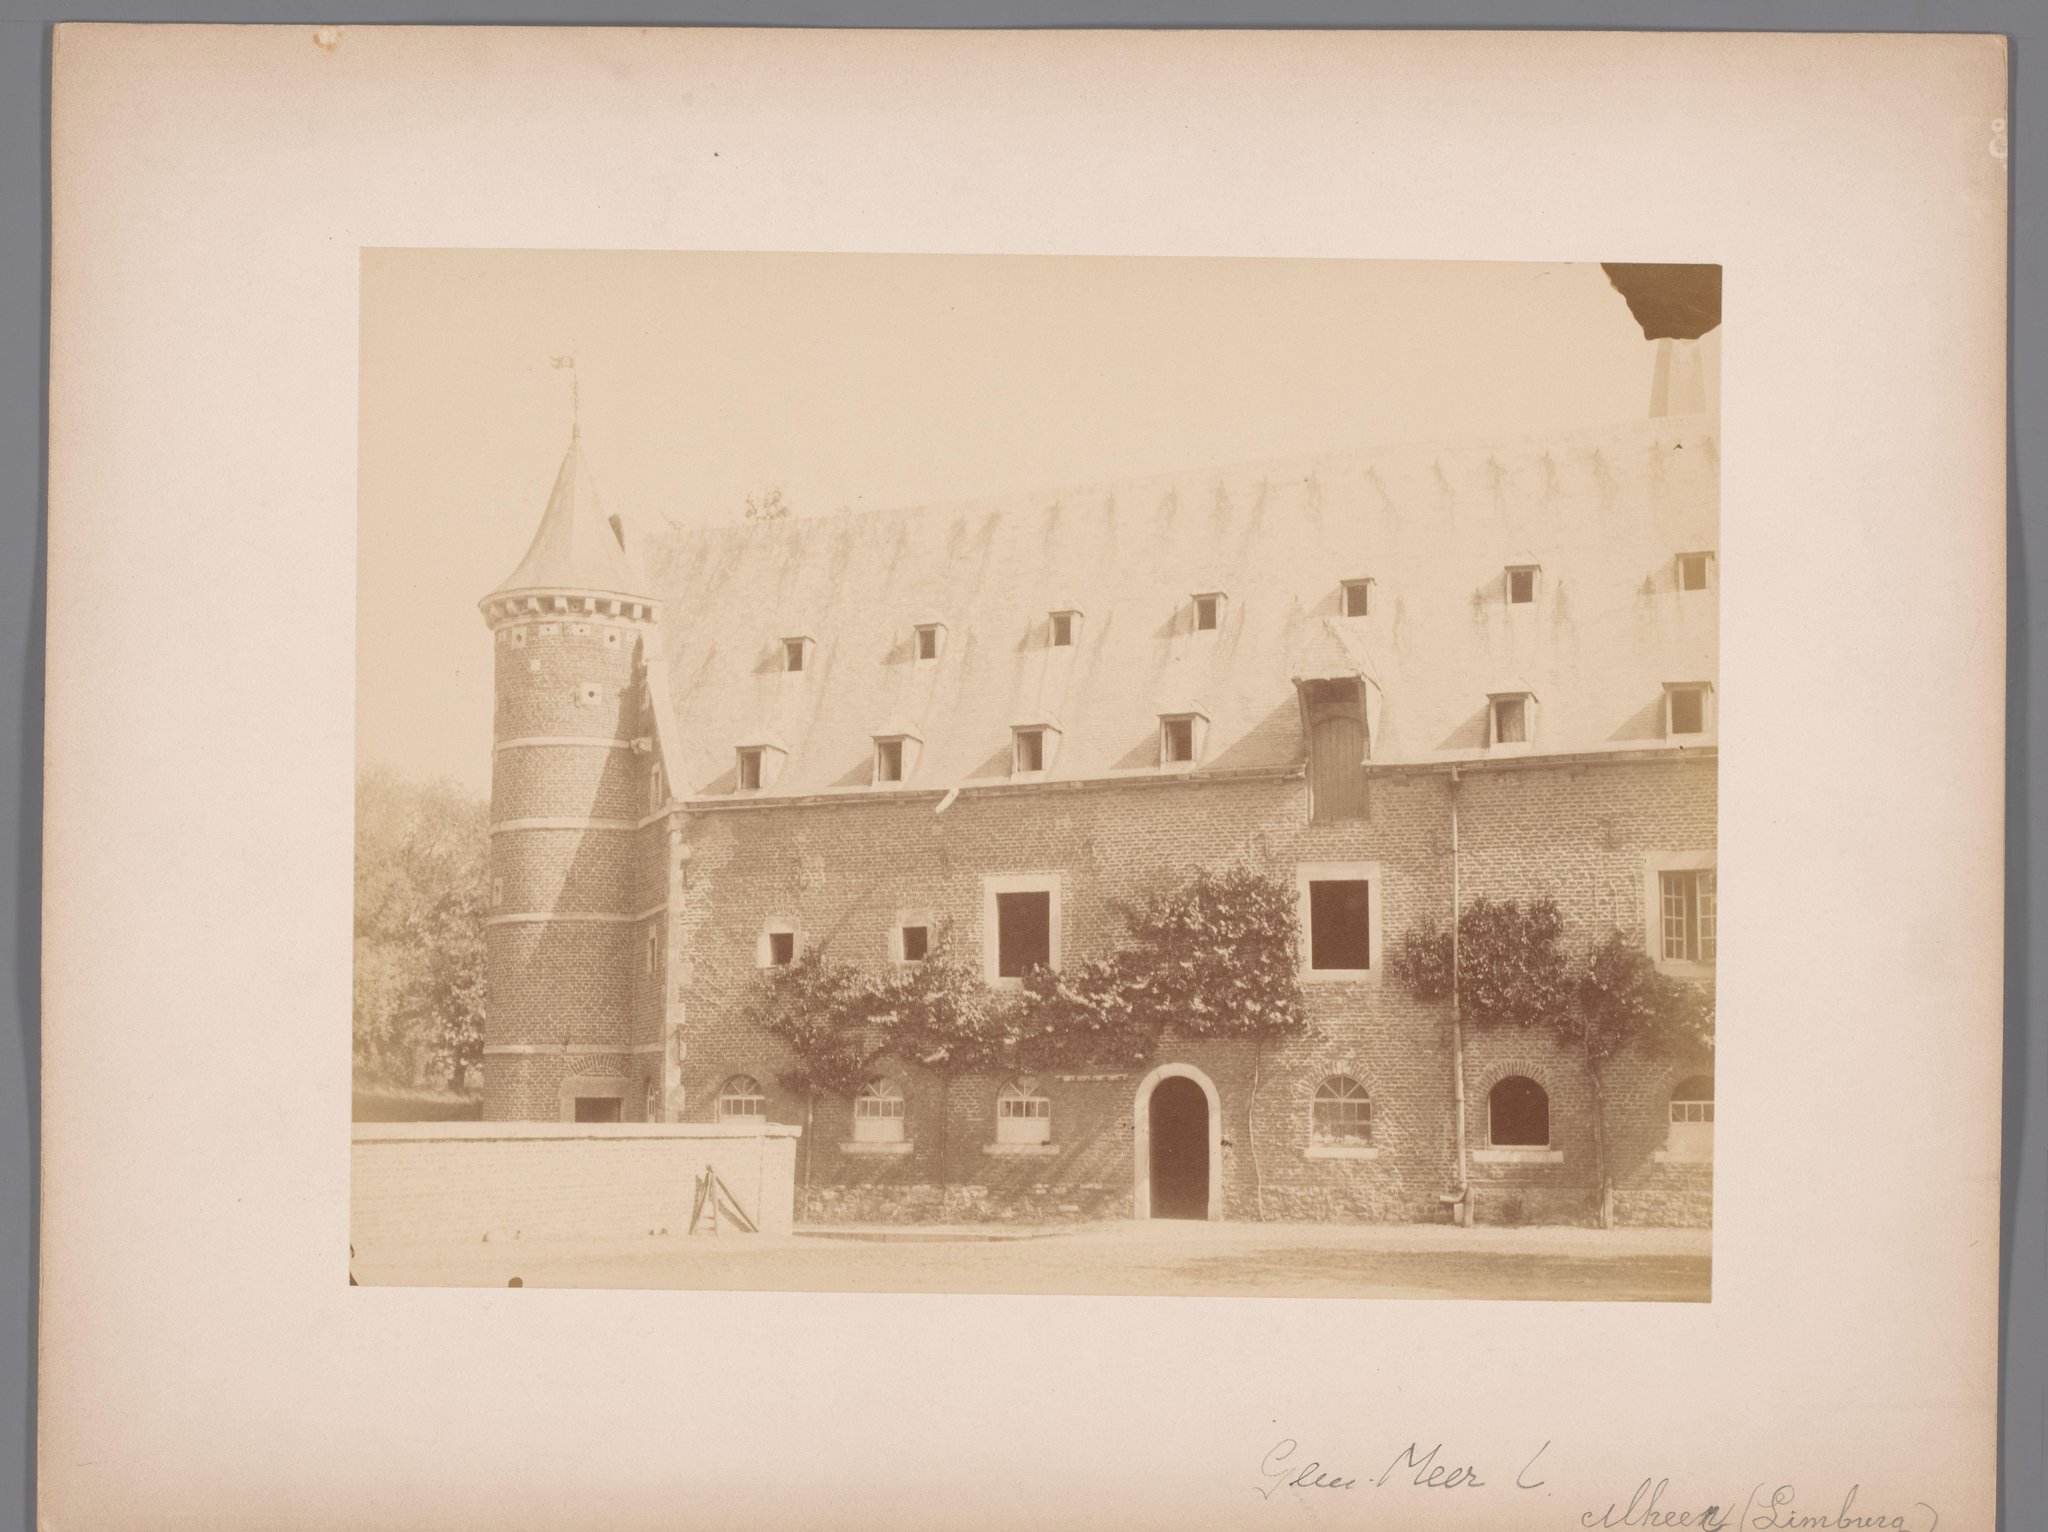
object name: photograph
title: Stallen bij het Kasteel van Mheer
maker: anoniem (monumentenzorg)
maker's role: fotograaf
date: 1890-1920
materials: cardboard, photographic support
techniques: albumen print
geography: limburg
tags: castle, stall, stable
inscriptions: annotation: ‘Gem. Meer. L/ Mheer (Limburg)’, annotation: ‘Mheer (Limburg)/ Kasteel en boerderij/ Aangezicht stalling’